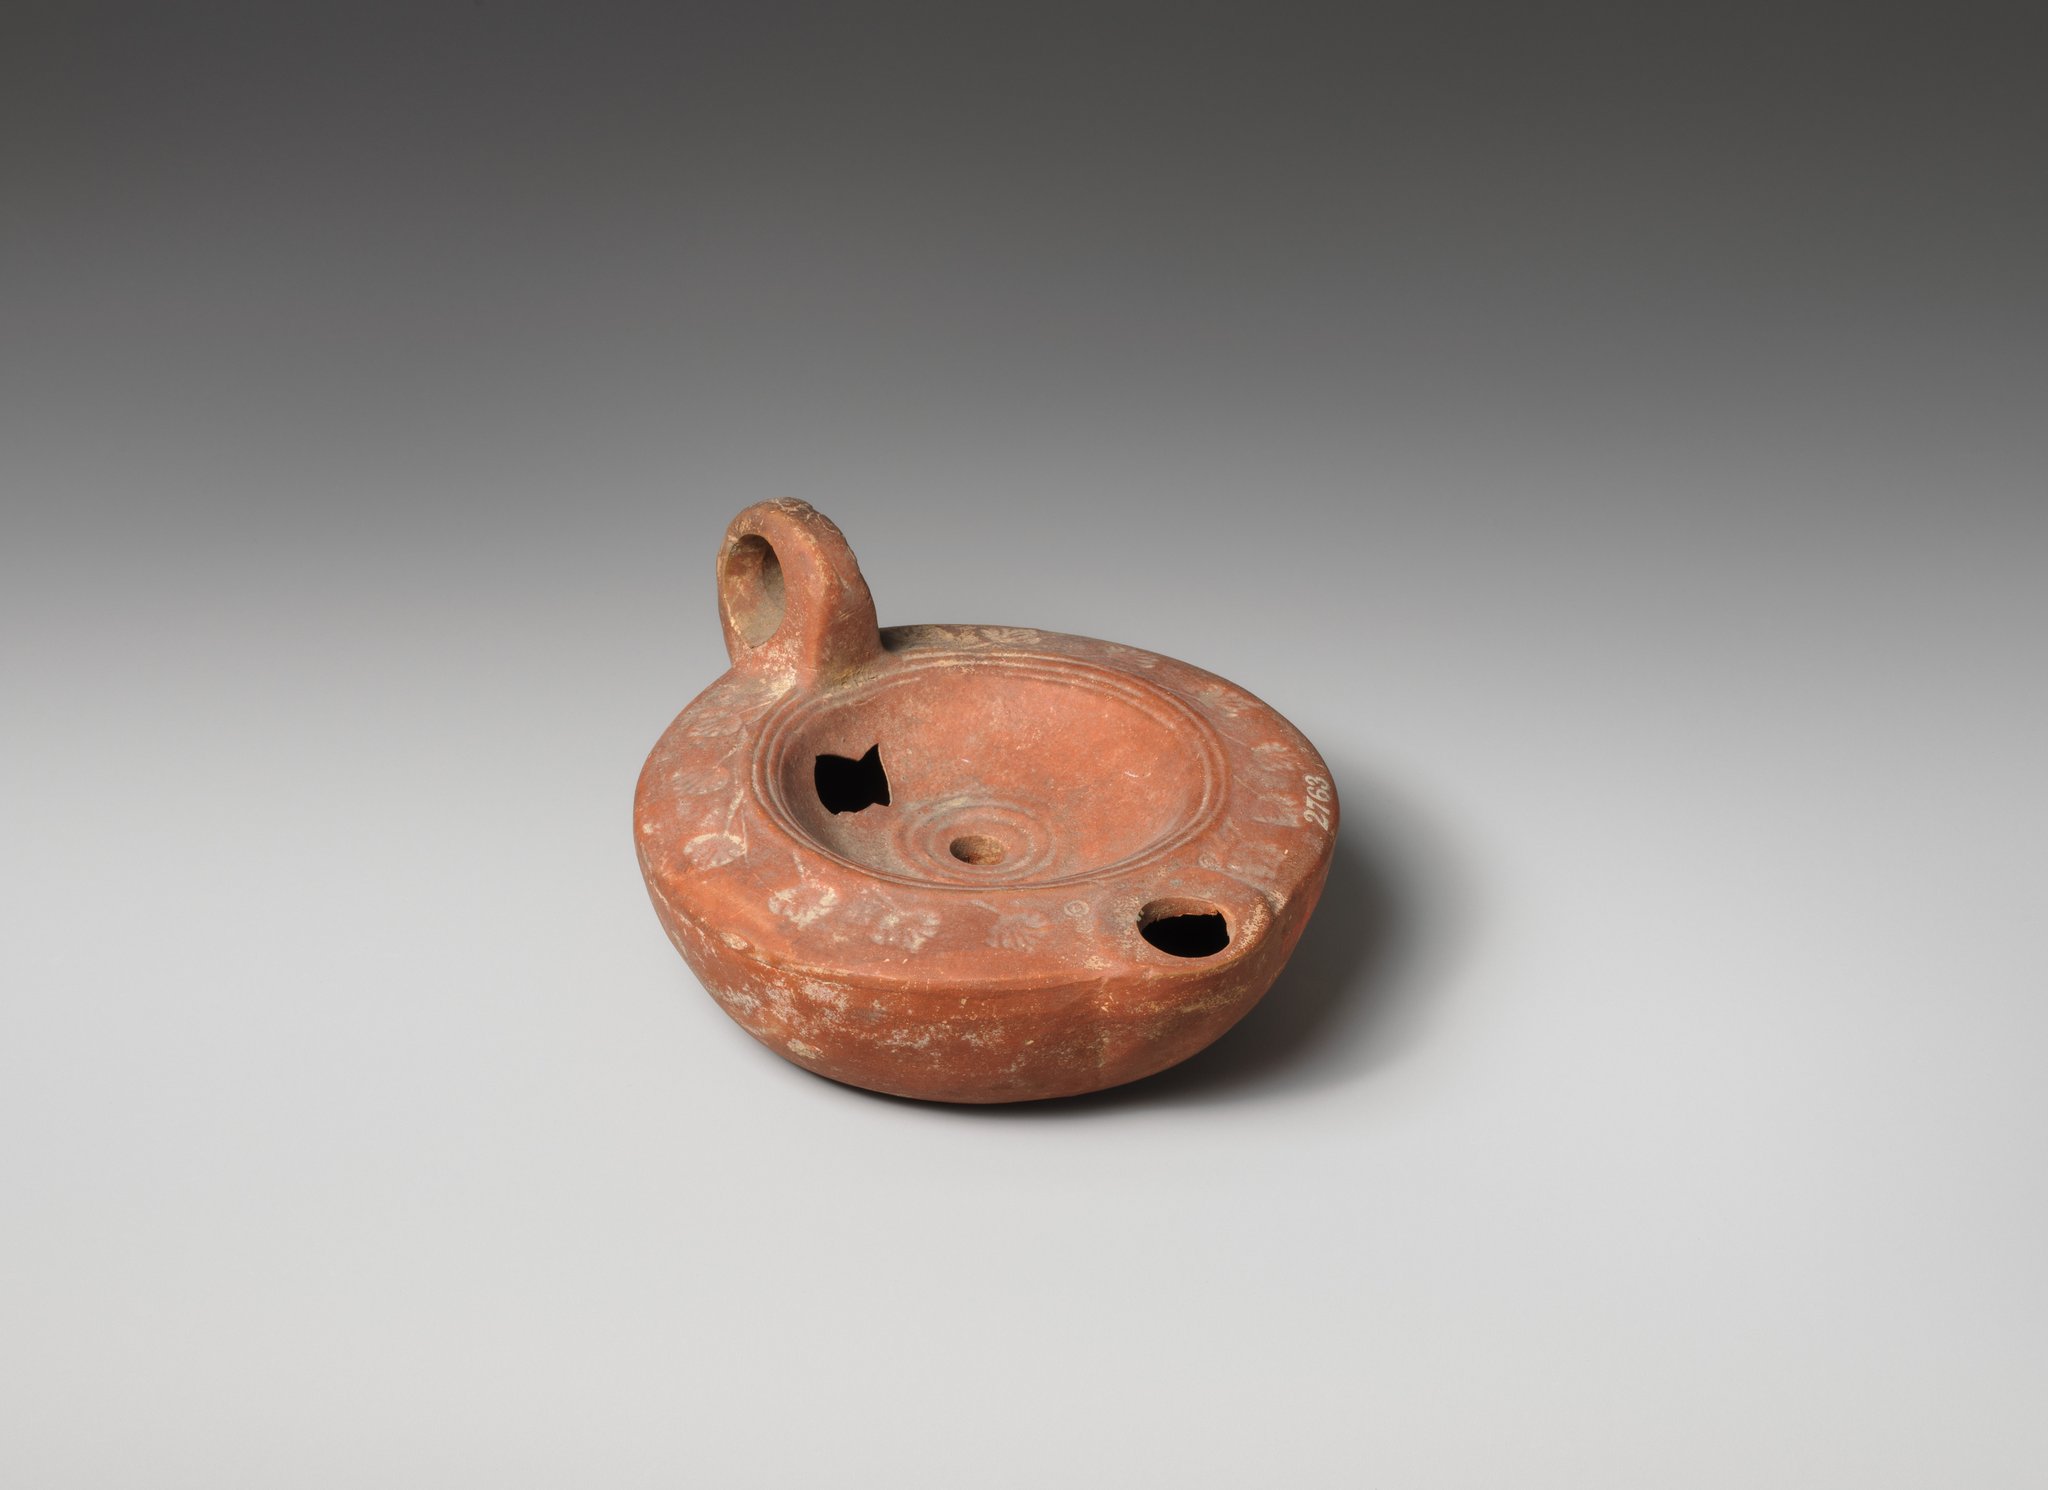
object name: lamp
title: Terracotta oil lamp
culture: roman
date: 101-200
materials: terracotta